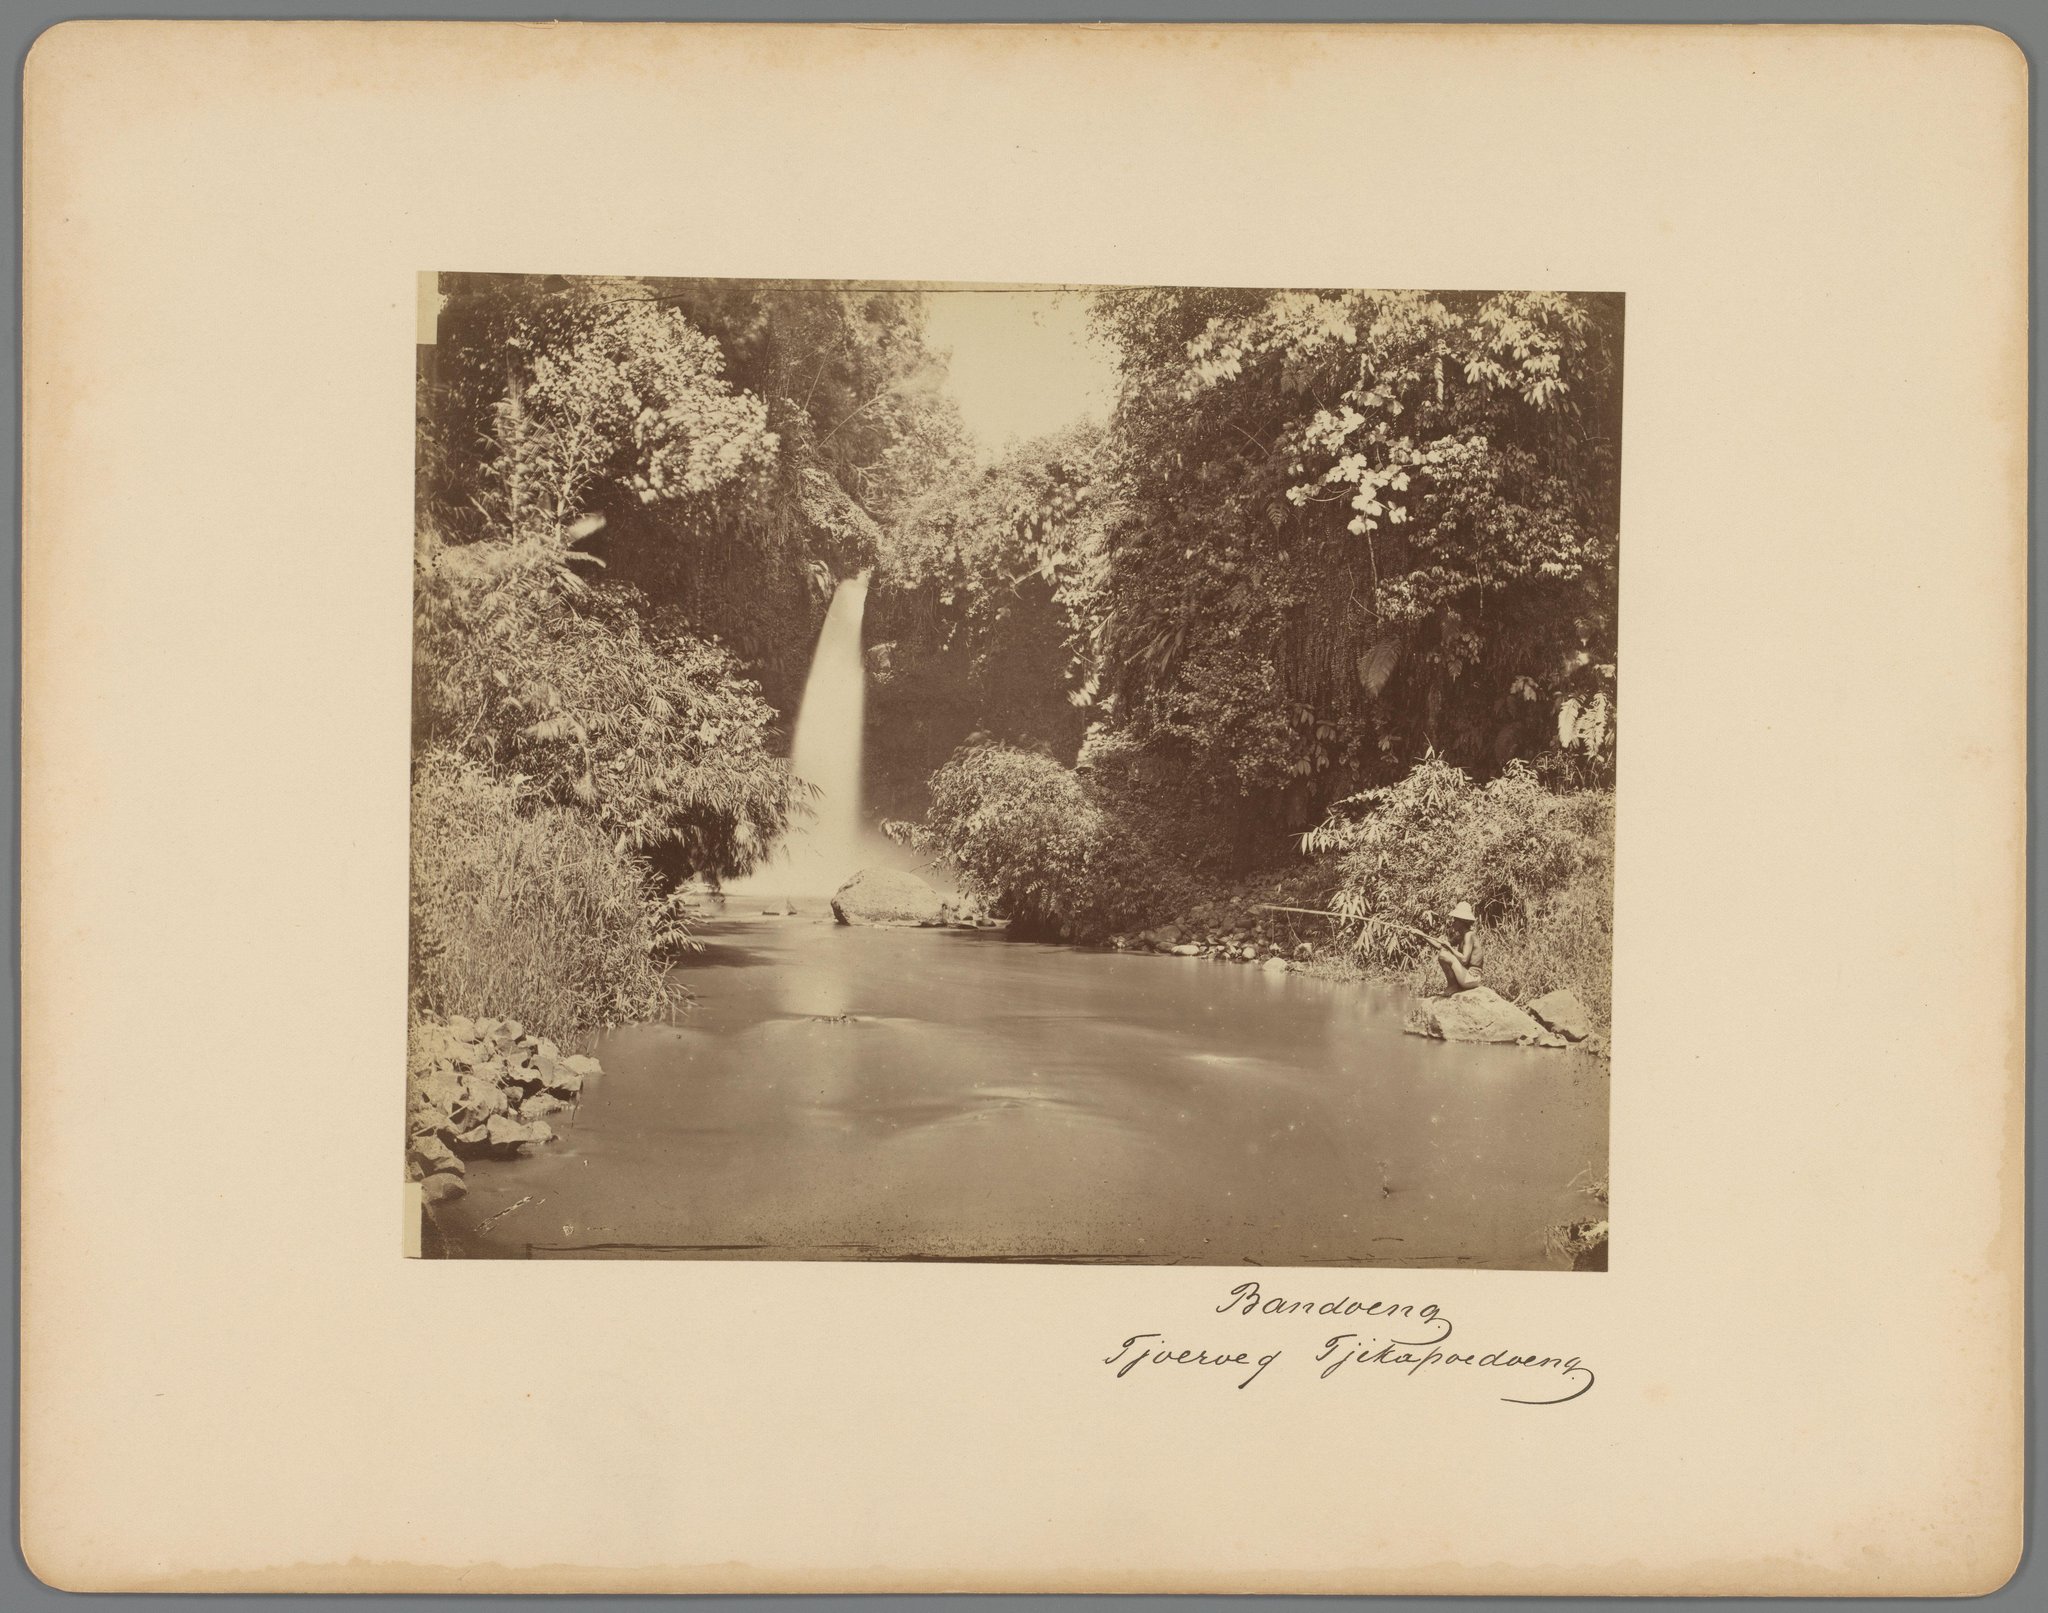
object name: photograph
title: Waterval op de hoogvlakte bij Bandung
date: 1857-1908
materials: cardboard, paper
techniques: albumen print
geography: bandung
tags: river, waterfall, landscapes in tropical and sub-tropical regions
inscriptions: inscription: ‘FOTO’, inscription: ‘Tjoeroeg Tjikapoedoeng/ Bandoeng’, inscription: ‘PHOTOGRAFIEEN VAN NED: INDIE BATAVIA’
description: Deze foto zat oorspronkelijk in prentenkabinet RP-F-AA3192.